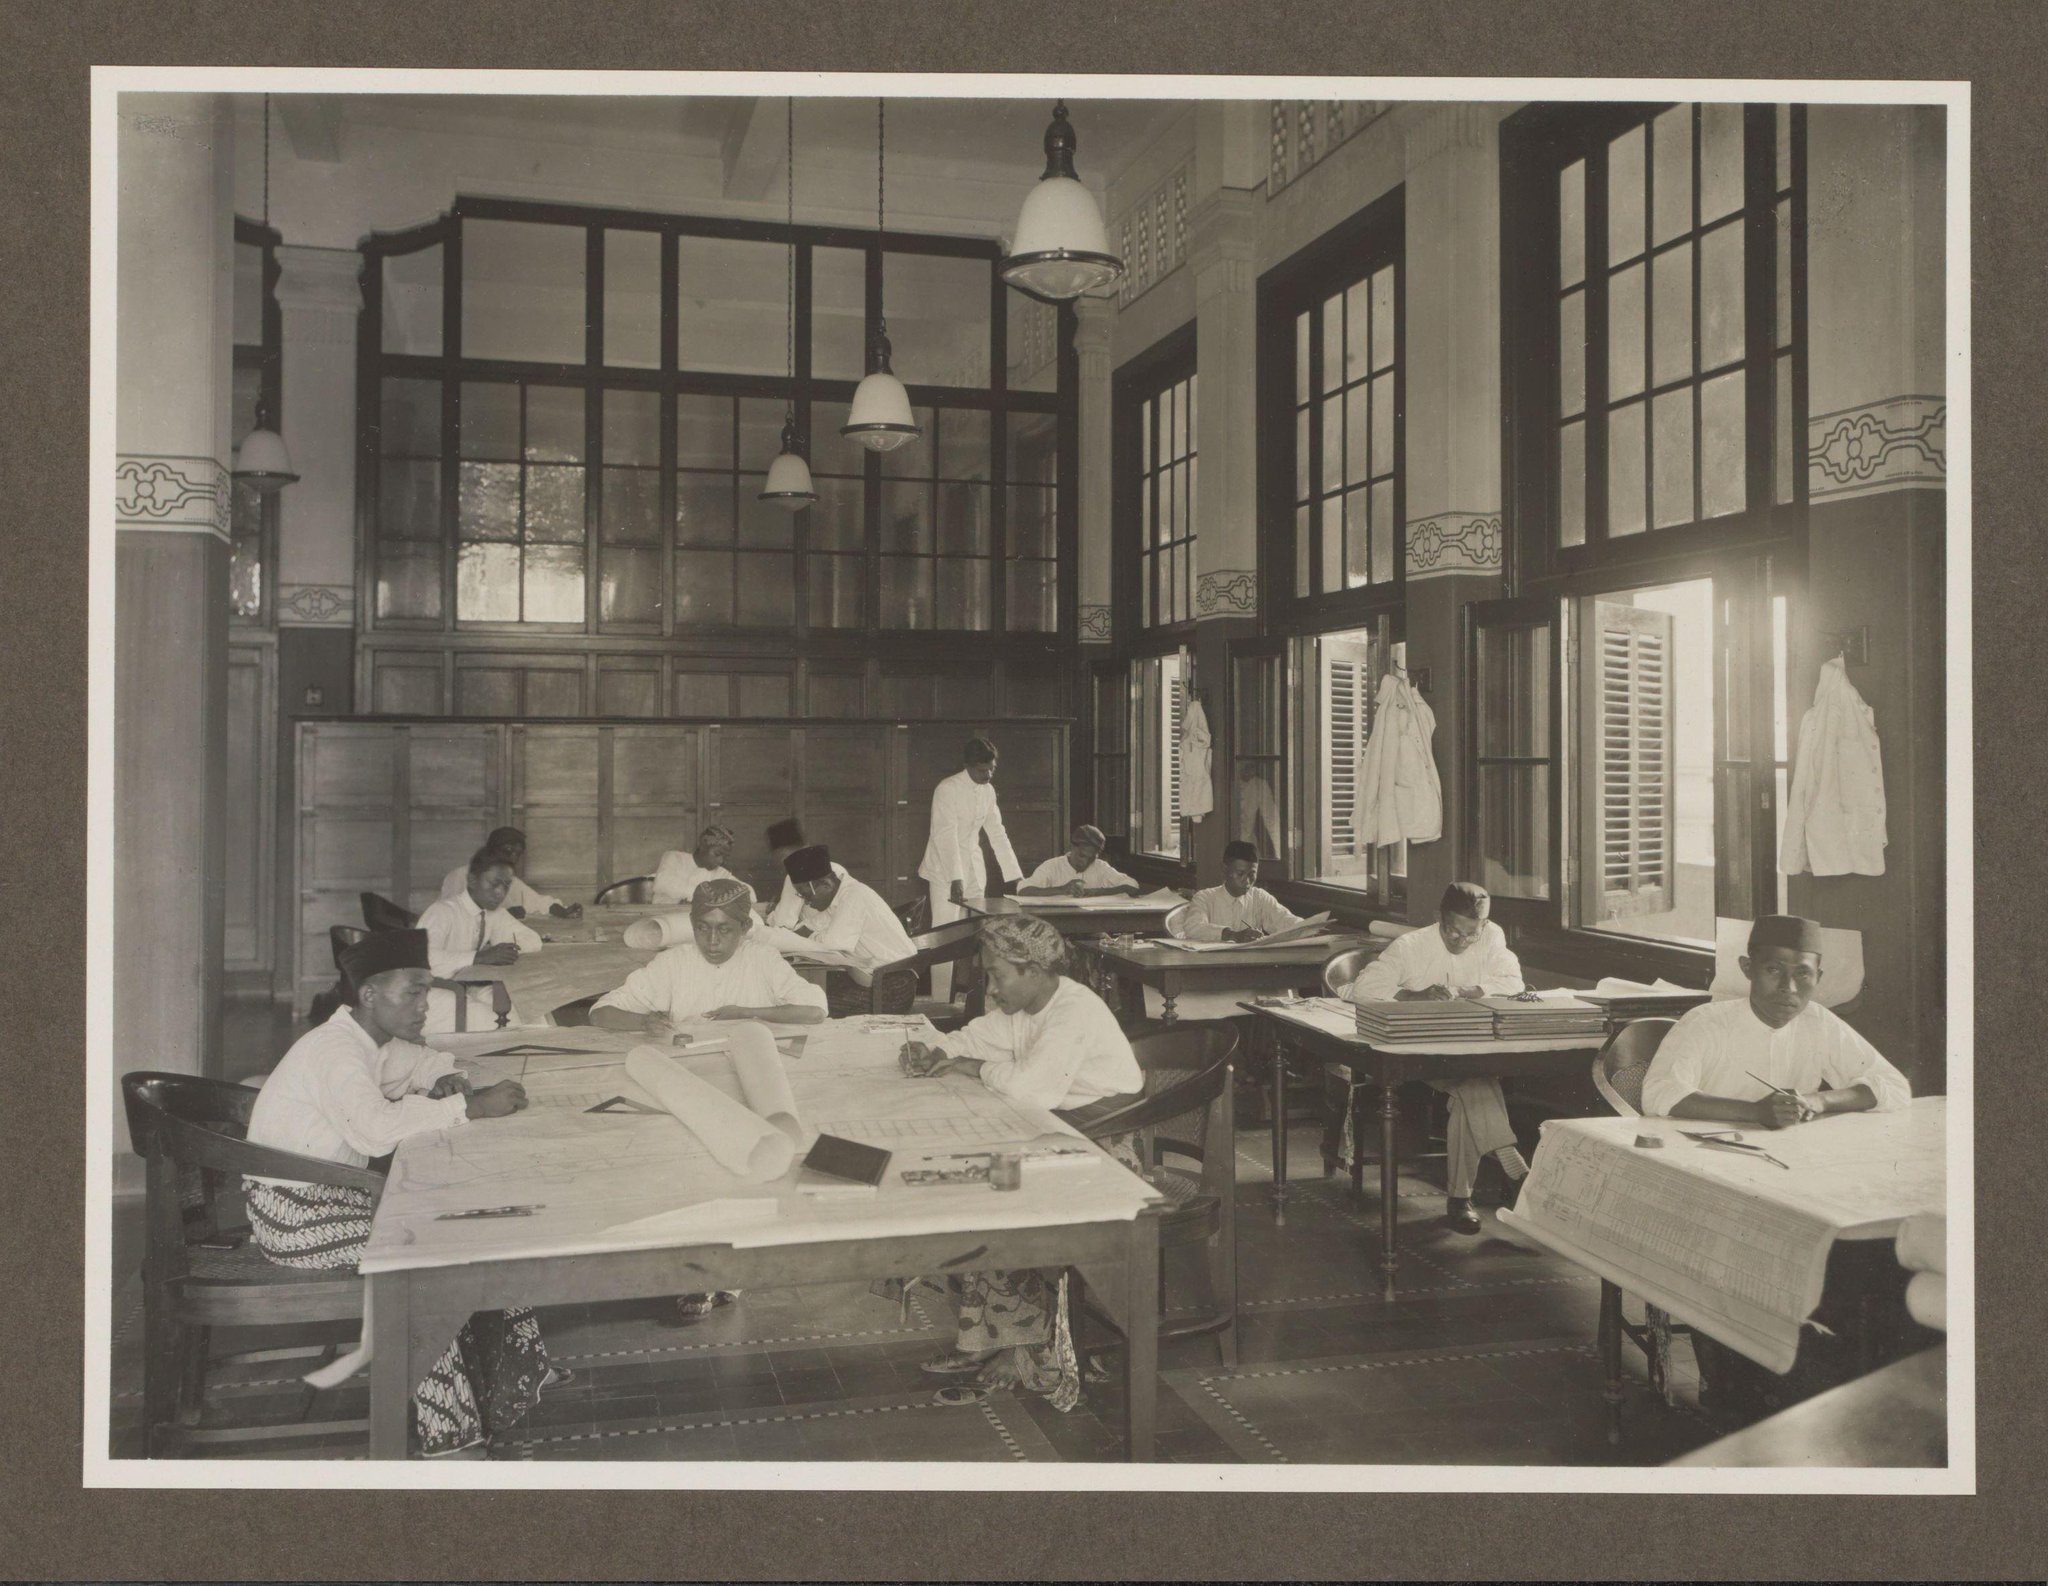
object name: photograph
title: Teekenzaal.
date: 1904-1931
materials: photographic support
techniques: gelatin silver print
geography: surabaya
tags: colonial system, trade-company, engineering, surabaya, java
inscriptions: inscription: ‘Teekenzaal.’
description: De tekenzaal waar Javaanse werknemers werken aan technische tekeningen. Foto in het het fotoalbum aangeboden aan A. van der Eyk namens de chefs en het personeel van de Handelsvereniging Amsterdam (HVA) te Soerabaja bij zijn vertrek van Java in april 1931.